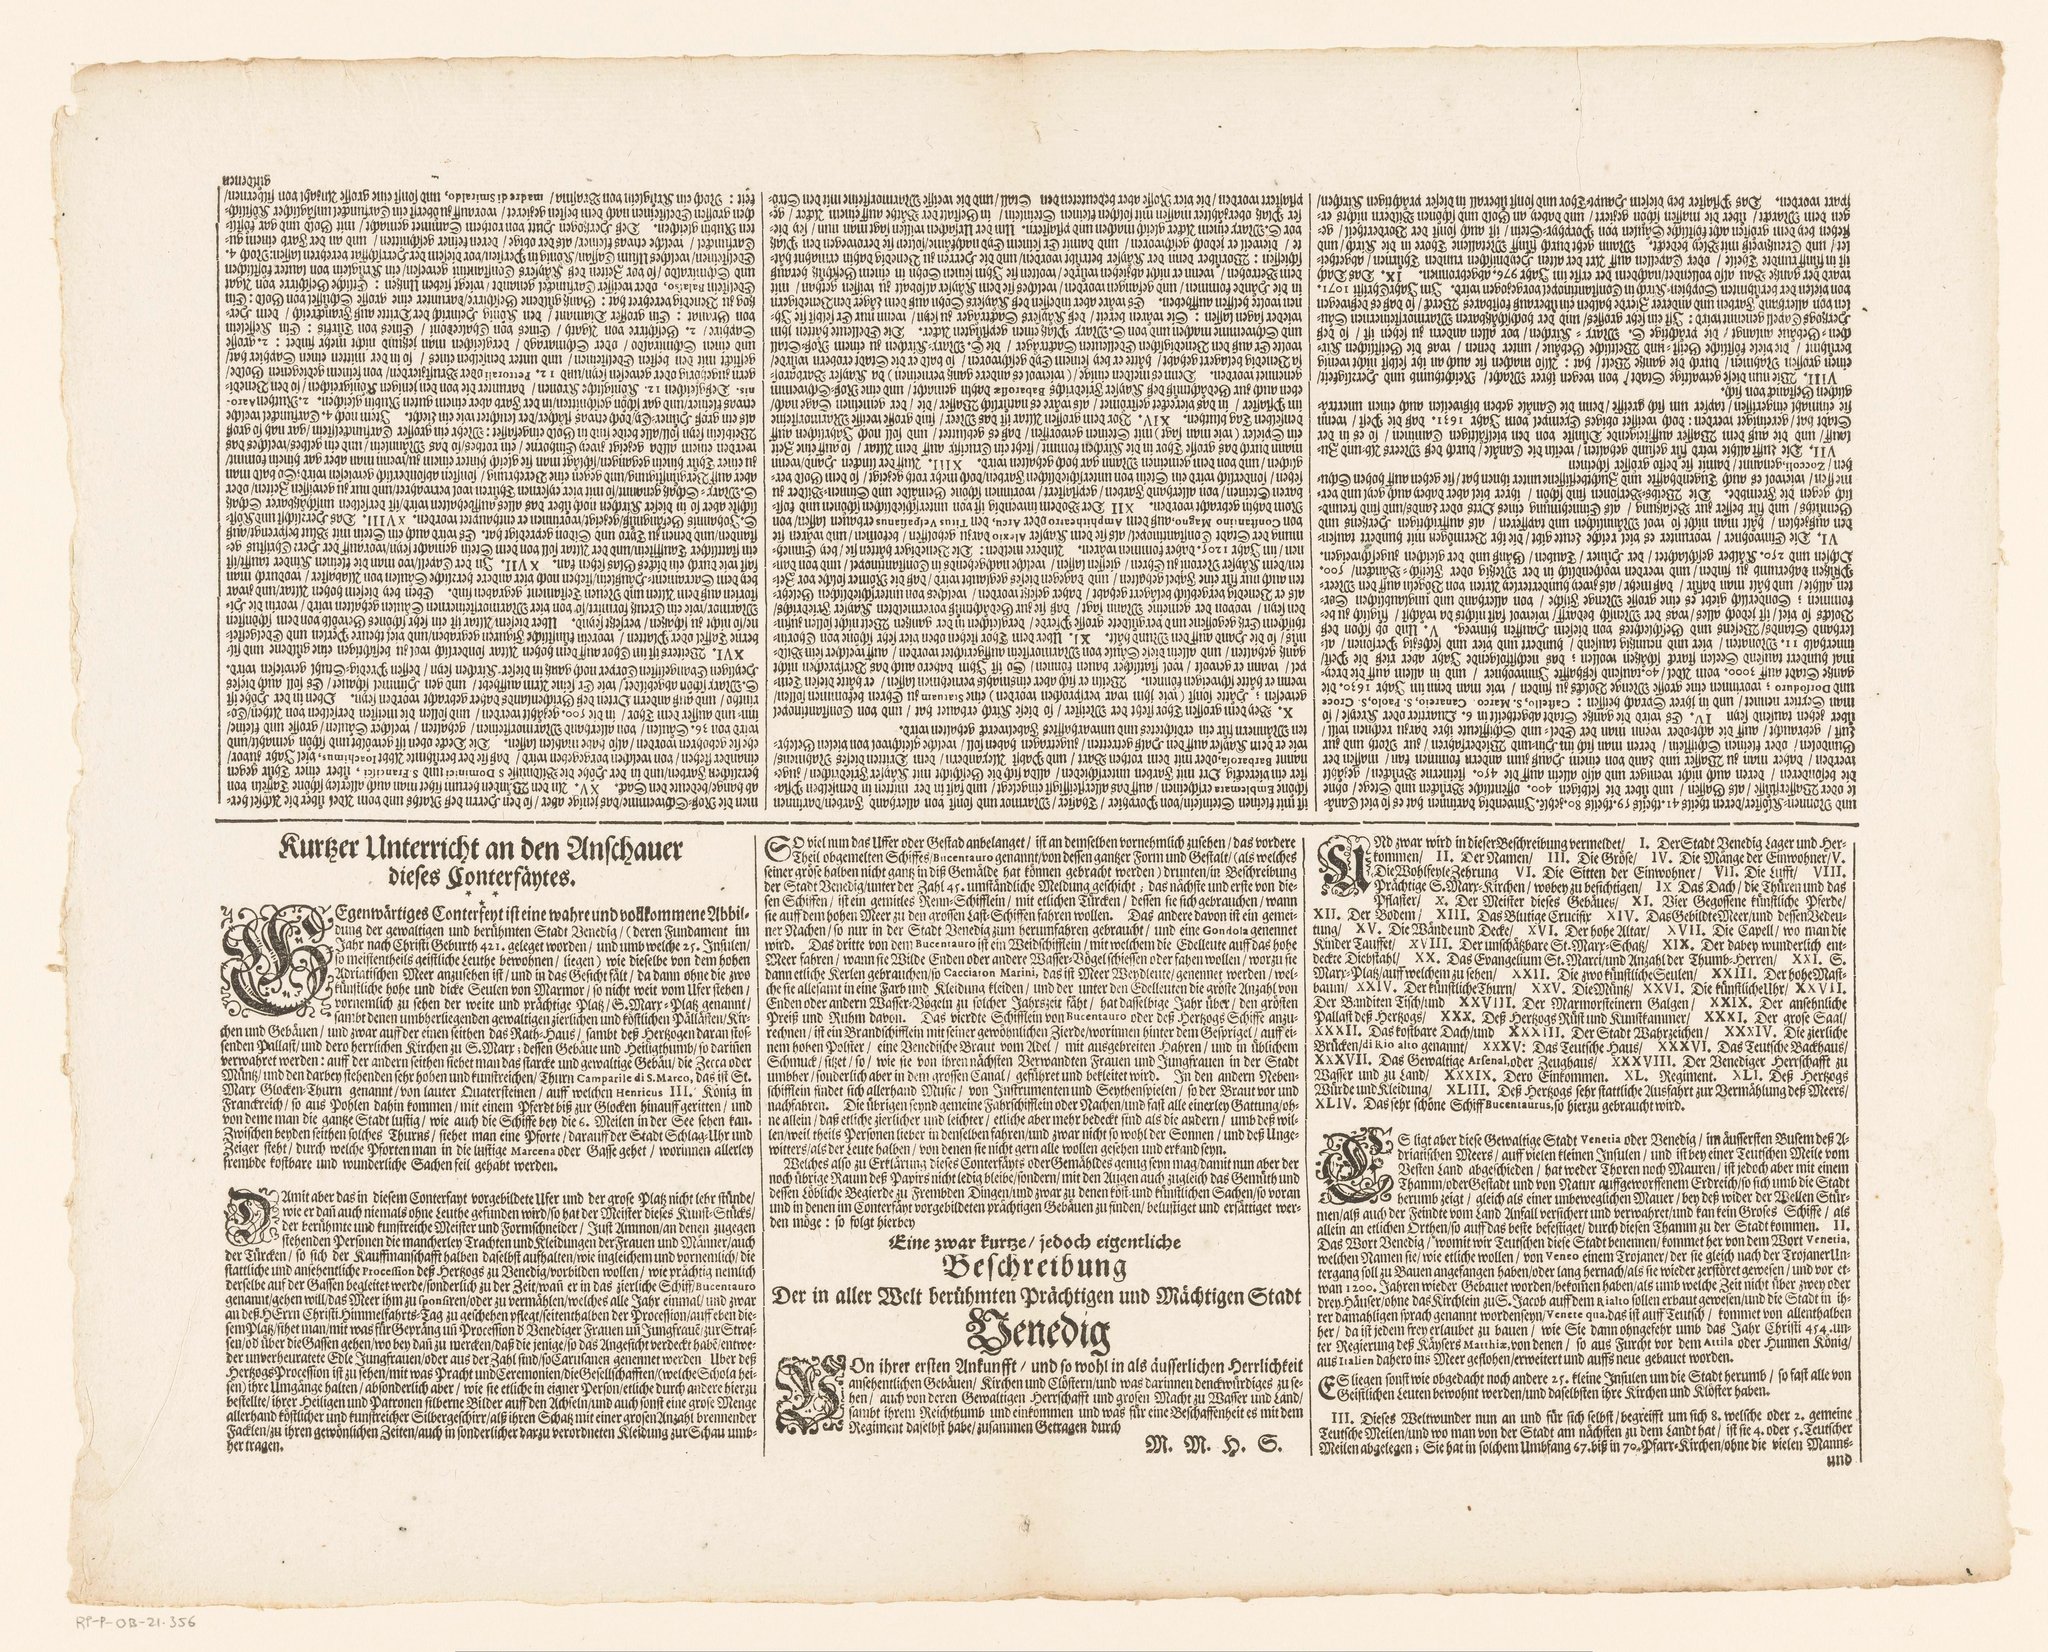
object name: text sheet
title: Ankunfft Und herkommen der weitberümbten herrlichen Statt Venedig Sambt derselben gewaltigen Herrschafft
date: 1697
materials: paper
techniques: letterpress printing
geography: frankfurt am main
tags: city-view in general; 'veduta', procession ~ christian religion, gondola, venice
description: Eerste en tweede gedeelte van een onderschrift behorende bij een prent van de Festa della Sensa. De voorstelling is gedrukt van veertien blokken, de titel van vijf blokken en het onderschrift bestaat uit vijf delen van elk drie kolommen Duits tekst. In de collectie Rijksmuseum bevinden zich twee complete exemplaren inclusief titel en onderschrift. Omdat niet alle delen van de titel en het onderschrift op afzonderlijke bladen zijn gedrukt, is dit exemplaar niet virtueel samengevoegd omwille van een betere presentatie. Zie voor het andere exemplaar: RP-P-2017-6073.